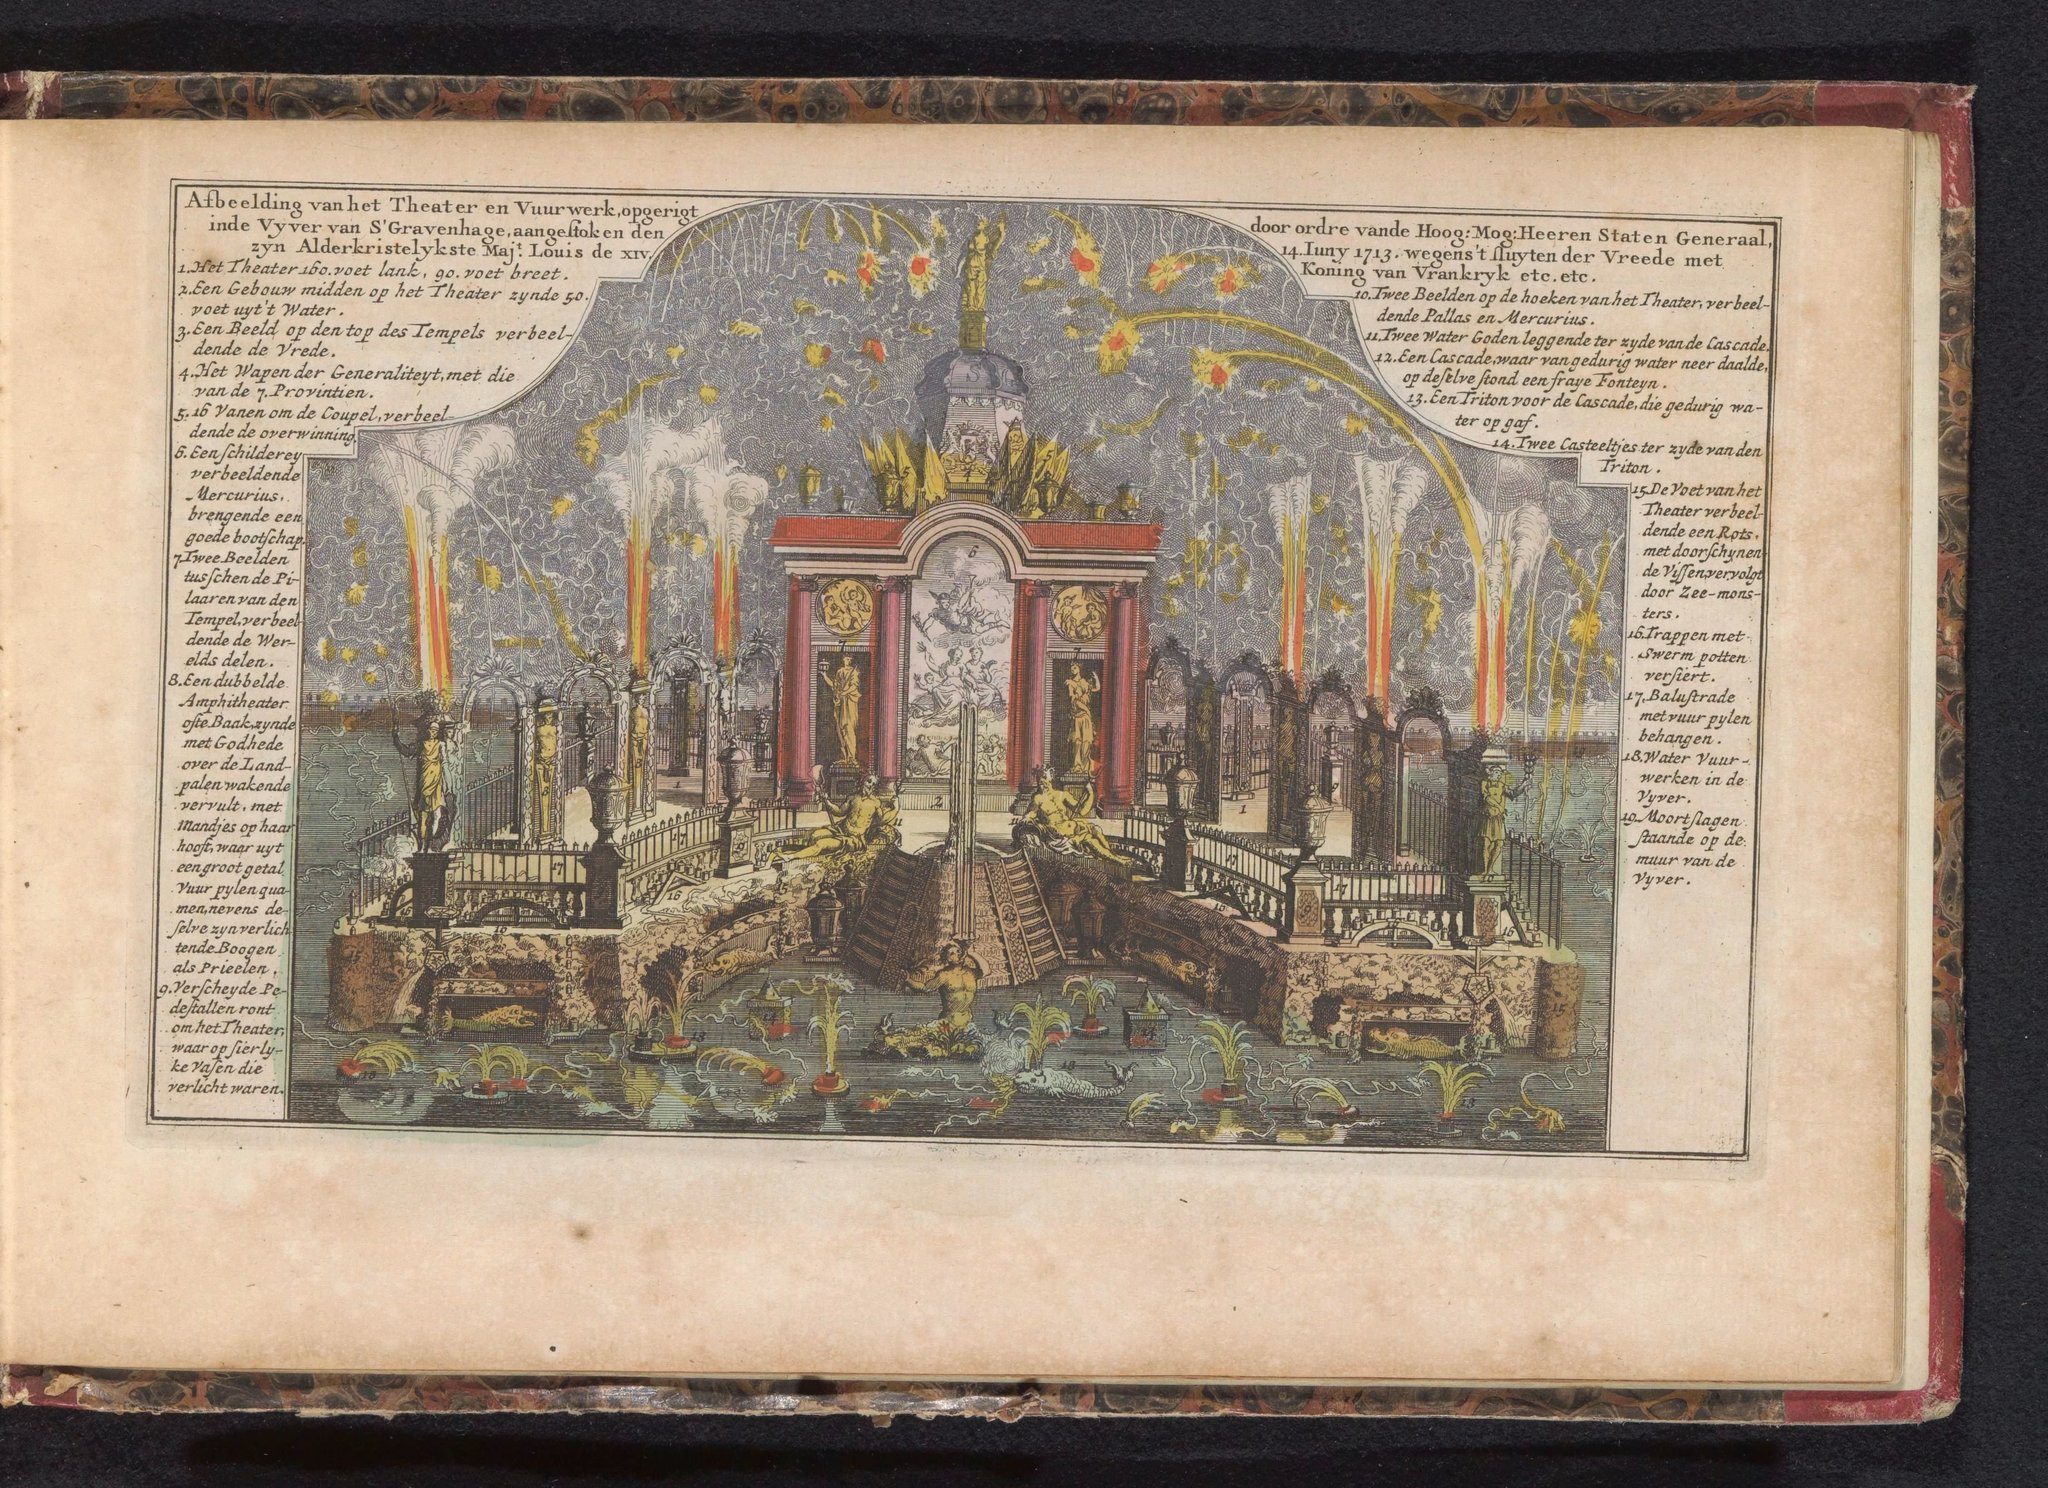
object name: print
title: Vuurwerk bij de viering van de Vrede van Utrecht, 1713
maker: Anonymous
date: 1713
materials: paper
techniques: etching, hand coloring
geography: amsterdam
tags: bonfire, fire-works, festivities (+ illumination, fire-works ~ festive activities)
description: Stellage met vuurwerk afgestoken in opdracht van de Staten-Generaal op de Hofvijver te 's-Gravenhage bij de viering van de Vrede van Utrecht, 14 juni 1713. Aan weerszijden van de voorstelling de titel en legenda in het Nederlands. Onderdeel van een atlas met 223 kaarten van landen en steden en oorlogstaferelen in Europa in de periode ca. 1690-1735.